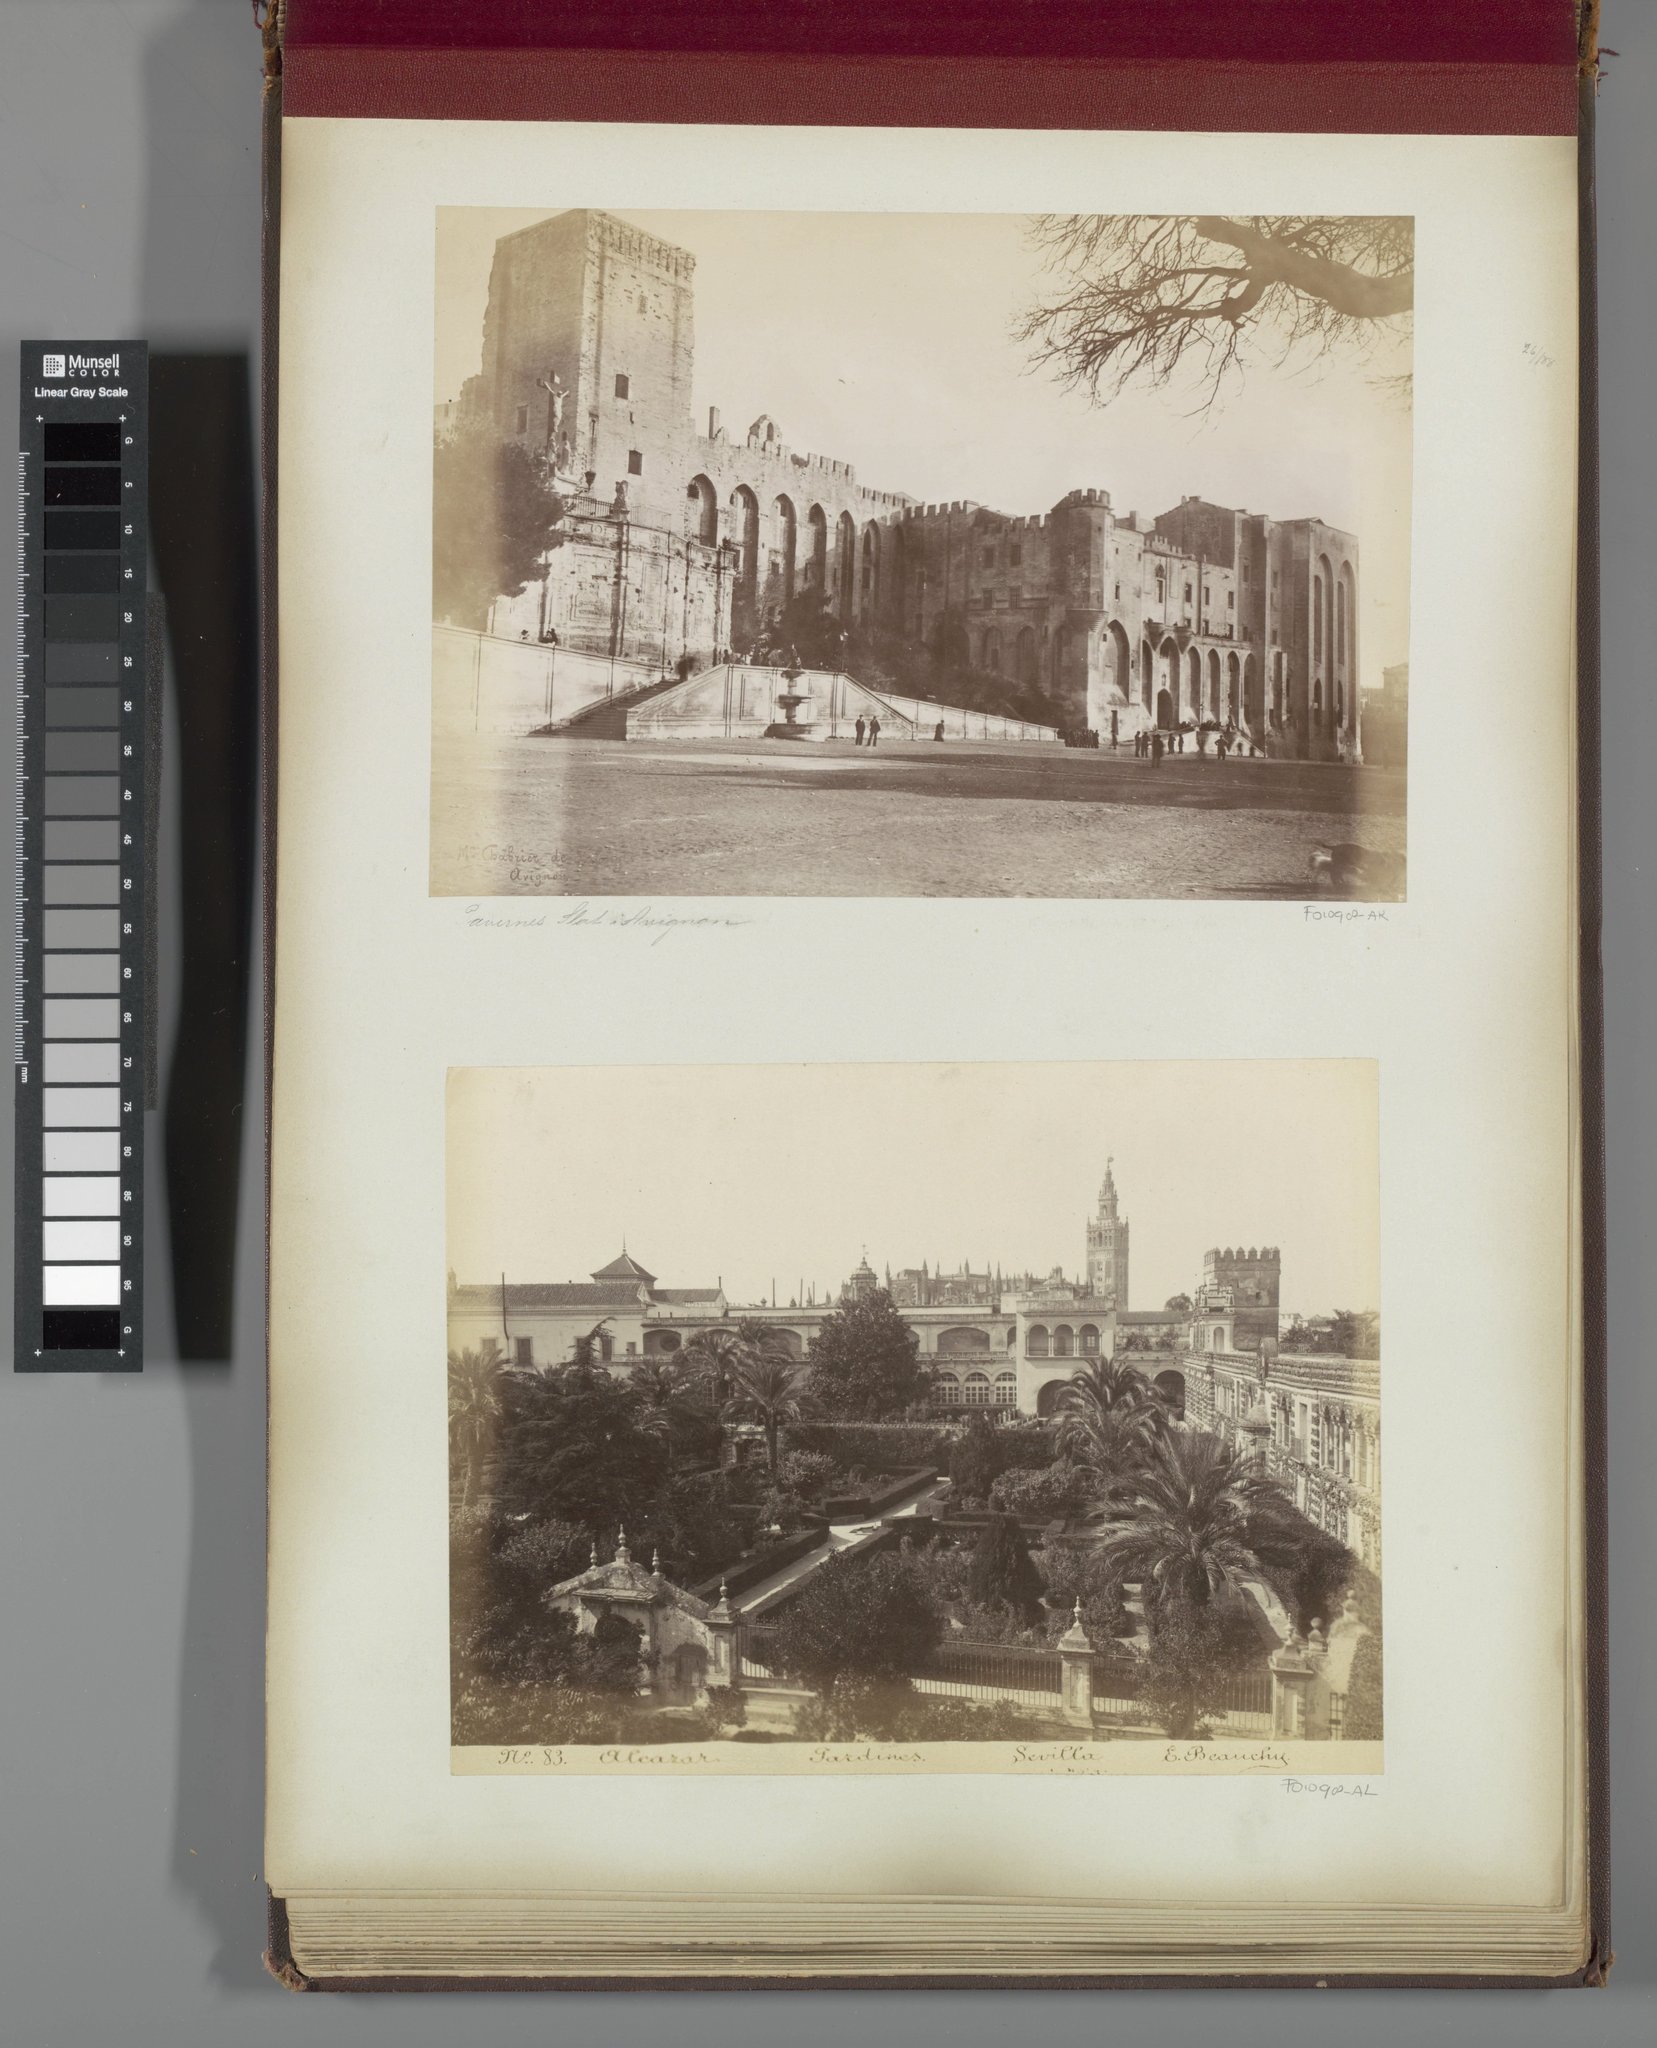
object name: photograph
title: Exterieur van het Pauselijk Paleis in Avignon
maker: franceline chabrier de de lafongt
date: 1860-1880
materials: cardboard, paper, photographic support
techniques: albumen print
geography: avignon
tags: palace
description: Onderdeel van Reisalbum met foto's van bezienswaardigheden in Spanje en Marokko.